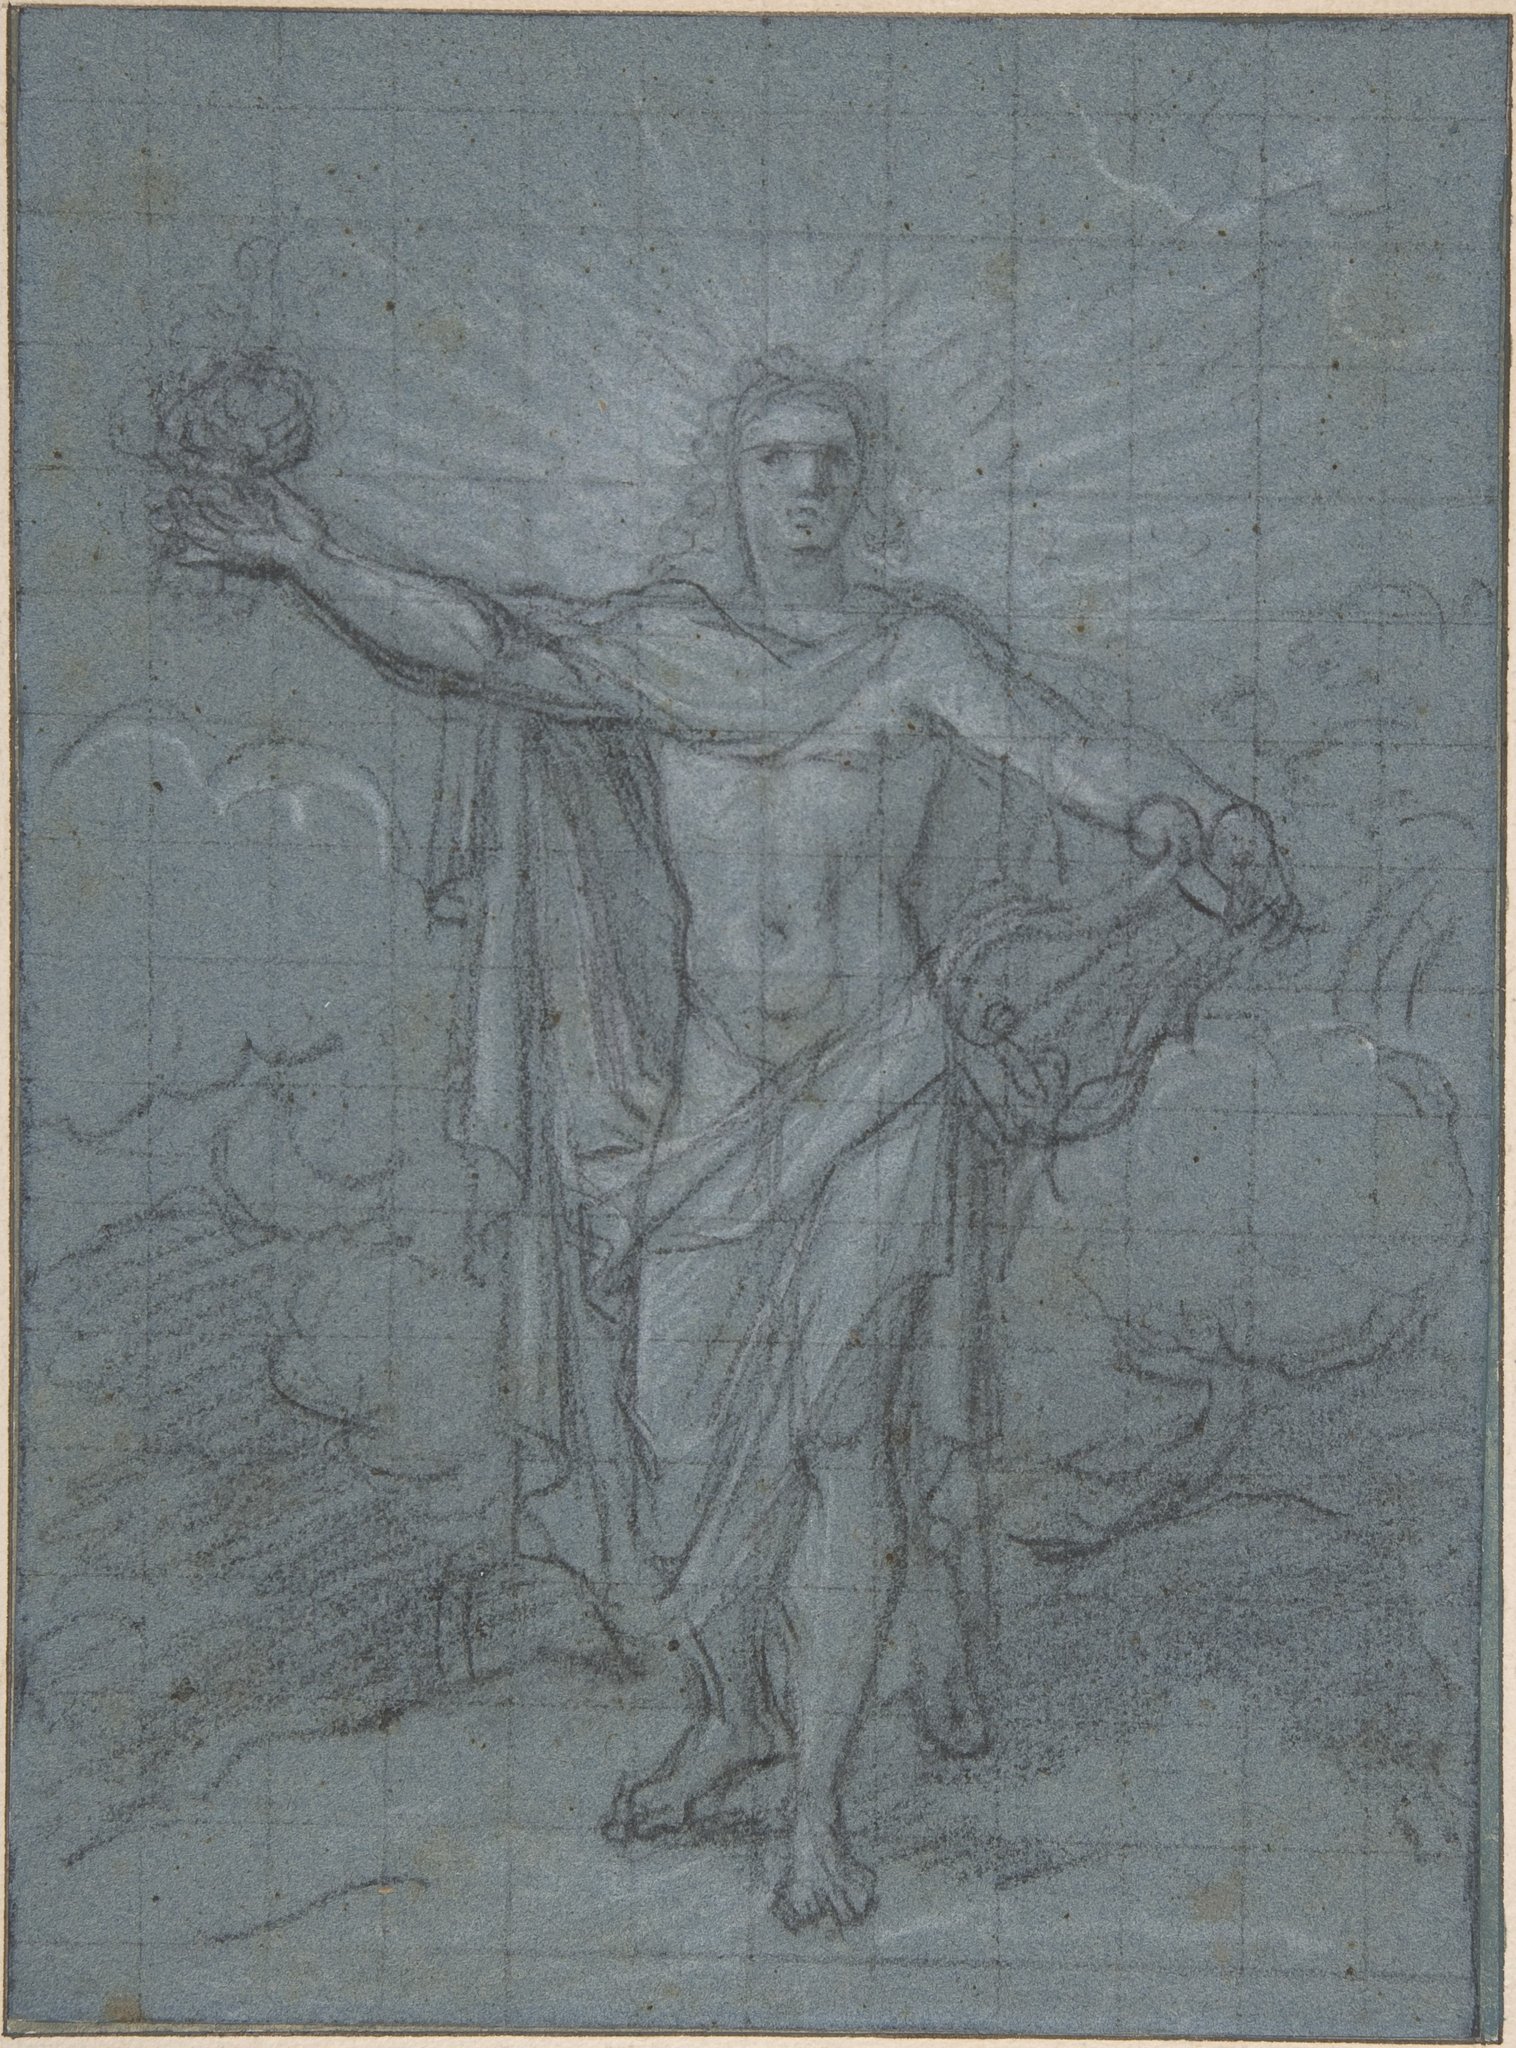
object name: drawing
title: Standing Figure of Apollo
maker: antoine coypel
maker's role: artist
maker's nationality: french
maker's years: 1661-1722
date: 1670-1725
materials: chalk, paper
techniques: drawing, transfer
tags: apollo